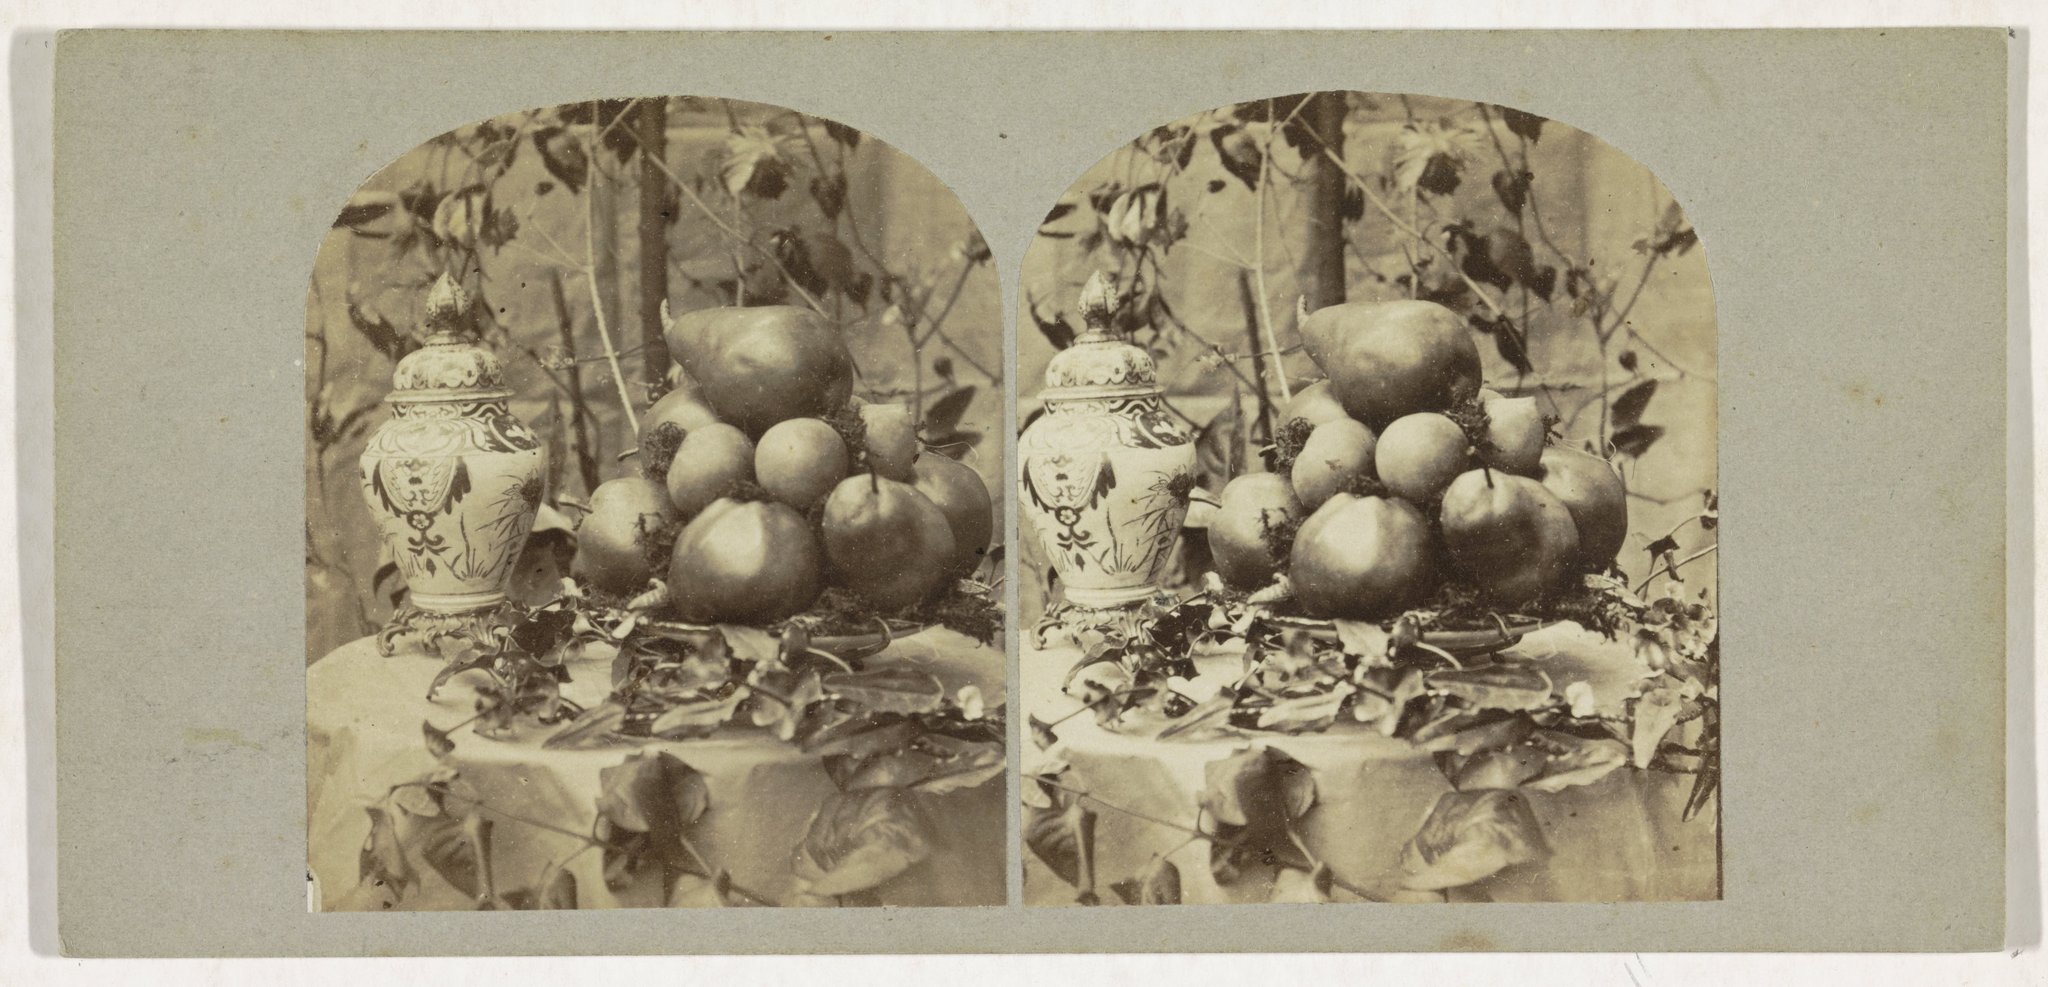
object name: stereograph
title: Still-life with a Jar, Pears and Leaves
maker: Anonymous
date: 1855-1865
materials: cardboard, paper, photographic support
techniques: albumen print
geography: great britain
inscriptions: inscription: ‘E 25 (?)’